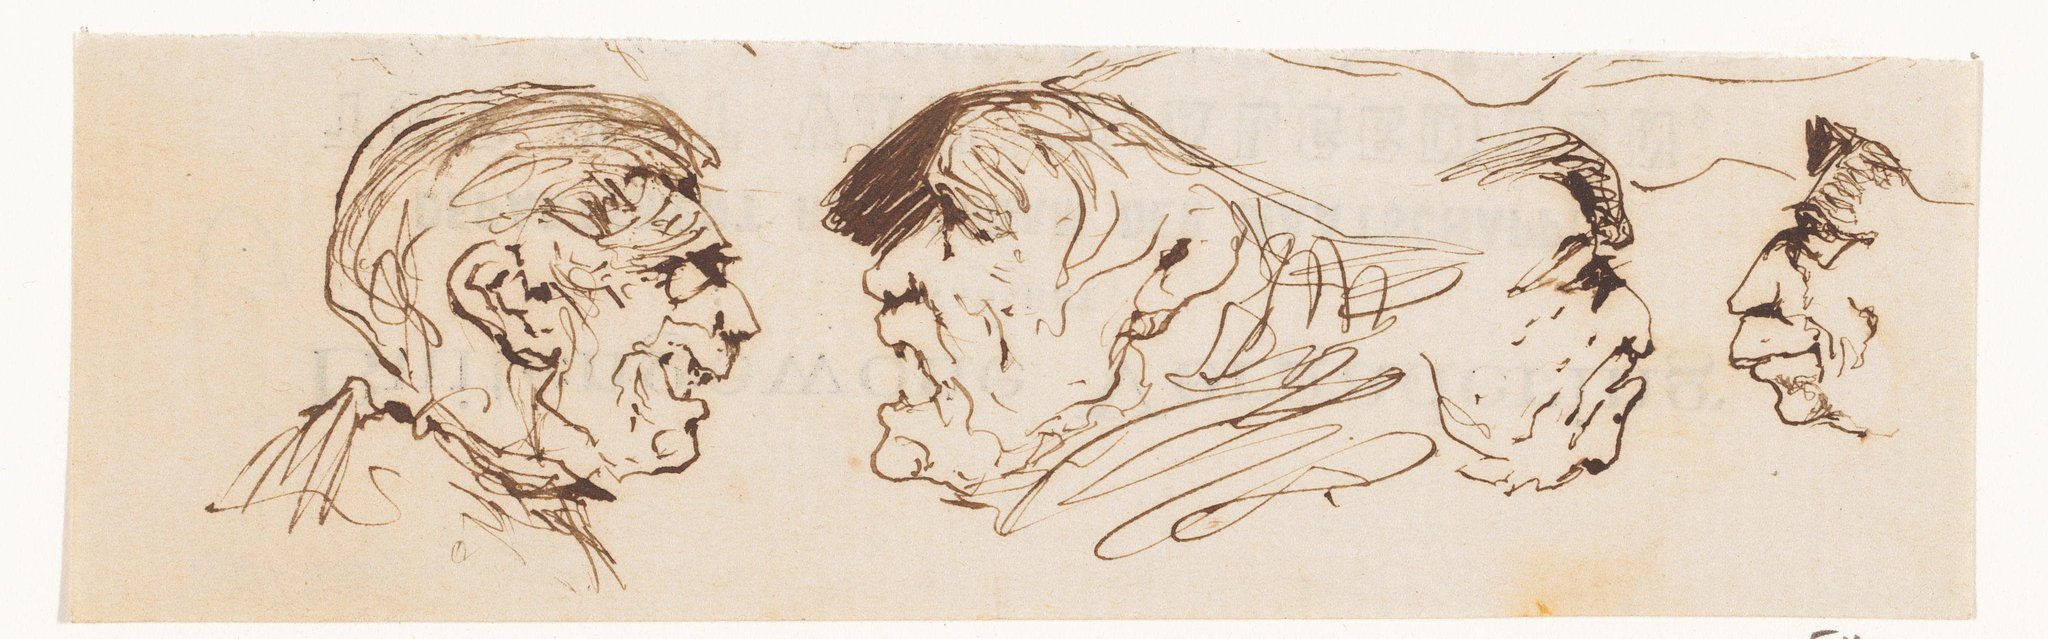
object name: drawing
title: Rijtje koppen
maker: johannes tavenraat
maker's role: draughtsman, painter, print maker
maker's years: 1809-1881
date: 1840-1880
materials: ink, paper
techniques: pen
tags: caricatures (human types)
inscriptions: collector's mark: Lugt 2228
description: Rijtje koppen. Getekend op de achterzijde van een fragment van een drukwerk van de Maatschappij tot Nut van 't Algemeen.